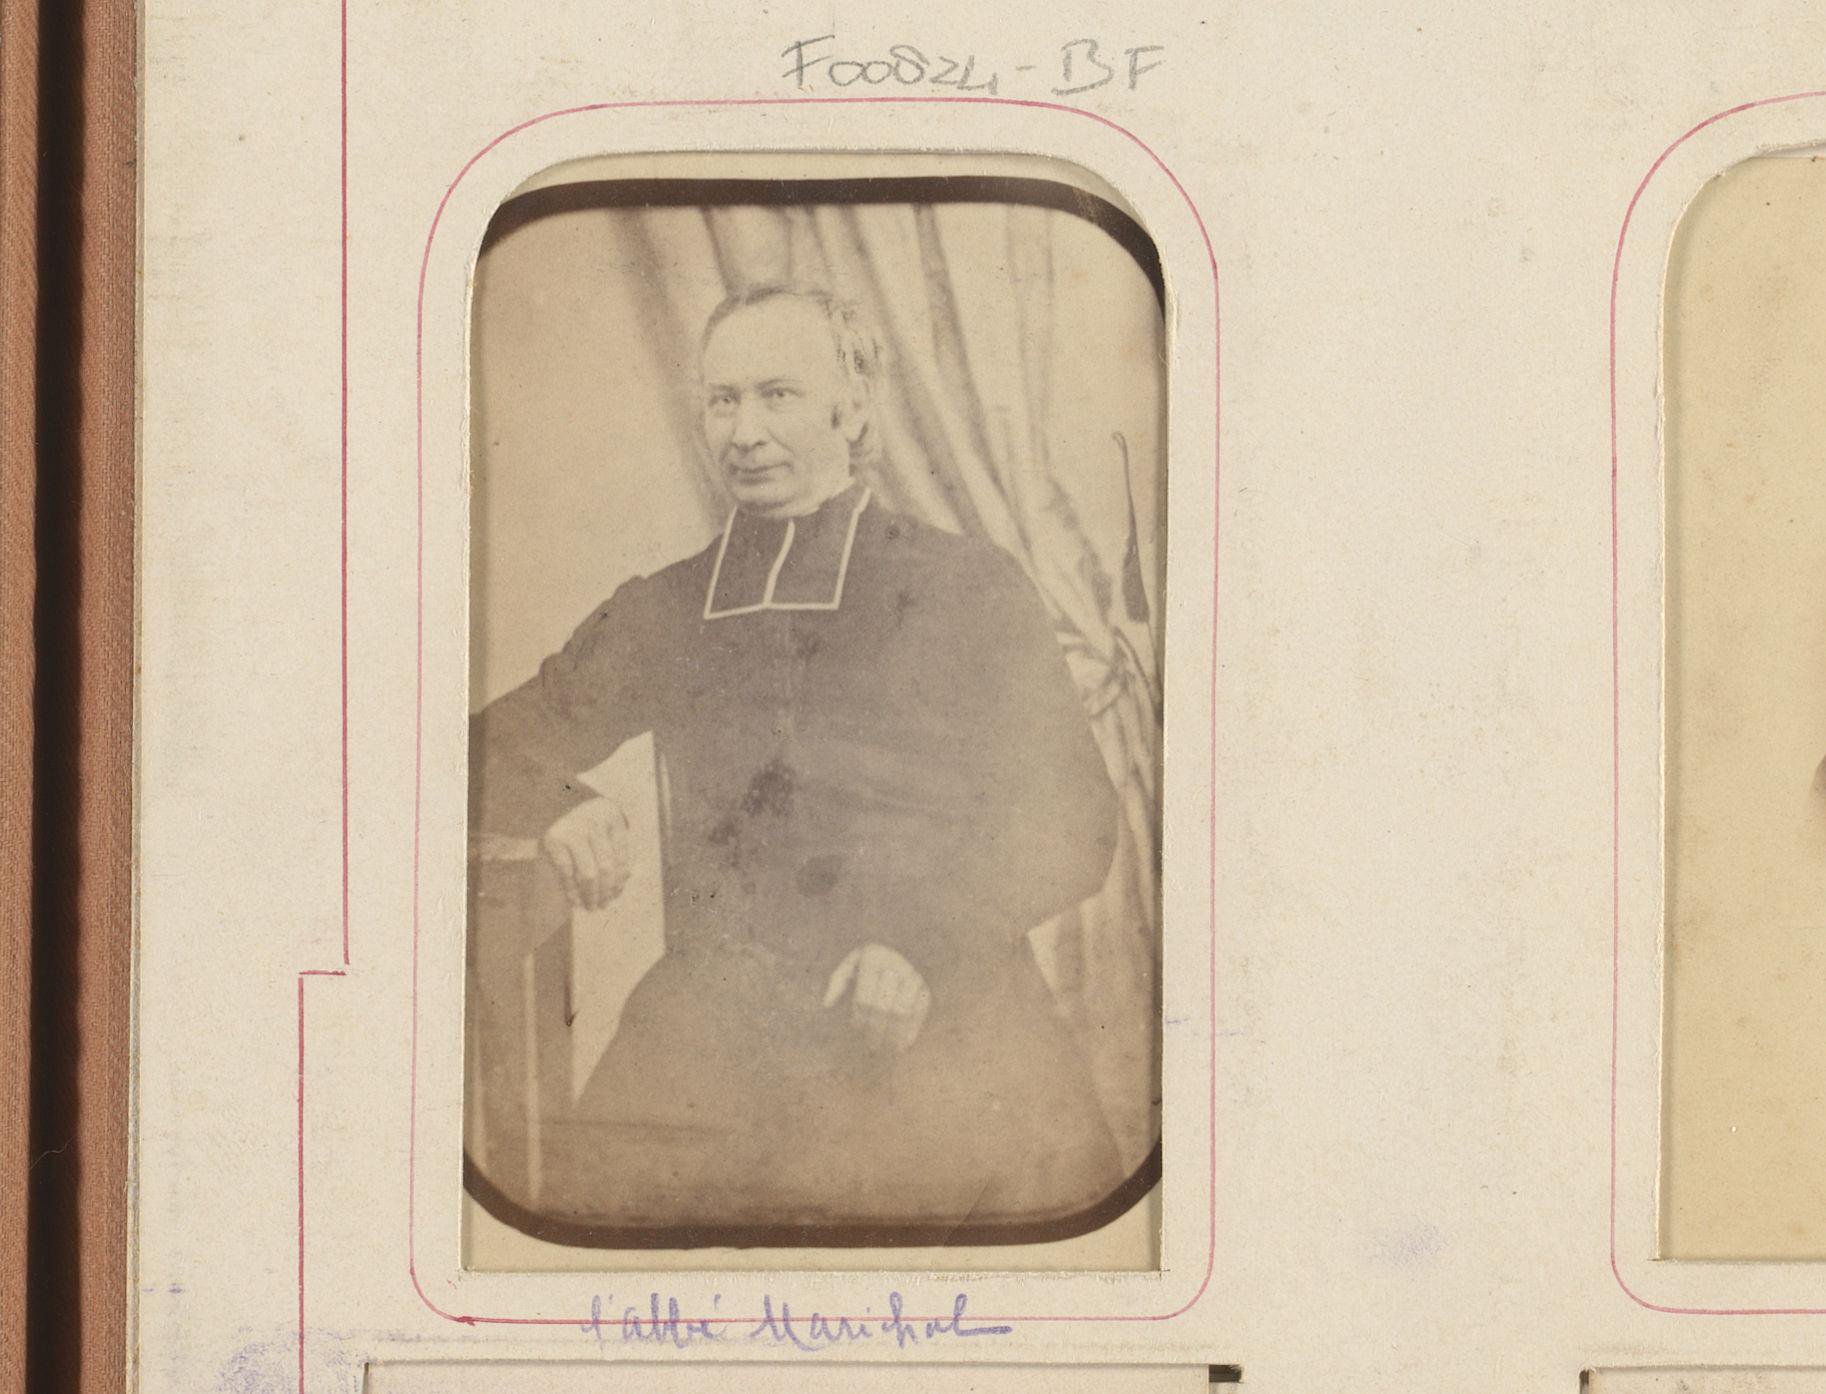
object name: album leaf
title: Portret van een abt, aangeduid als L'abbé Maréchal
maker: e. faure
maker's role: fotograaf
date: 1854-1885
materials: cardboard, paper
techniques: albumen print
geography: moselle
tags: abbot, anonymous historical person portrayed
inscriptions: address: ‘A SARRALBE/ (Moselle)’